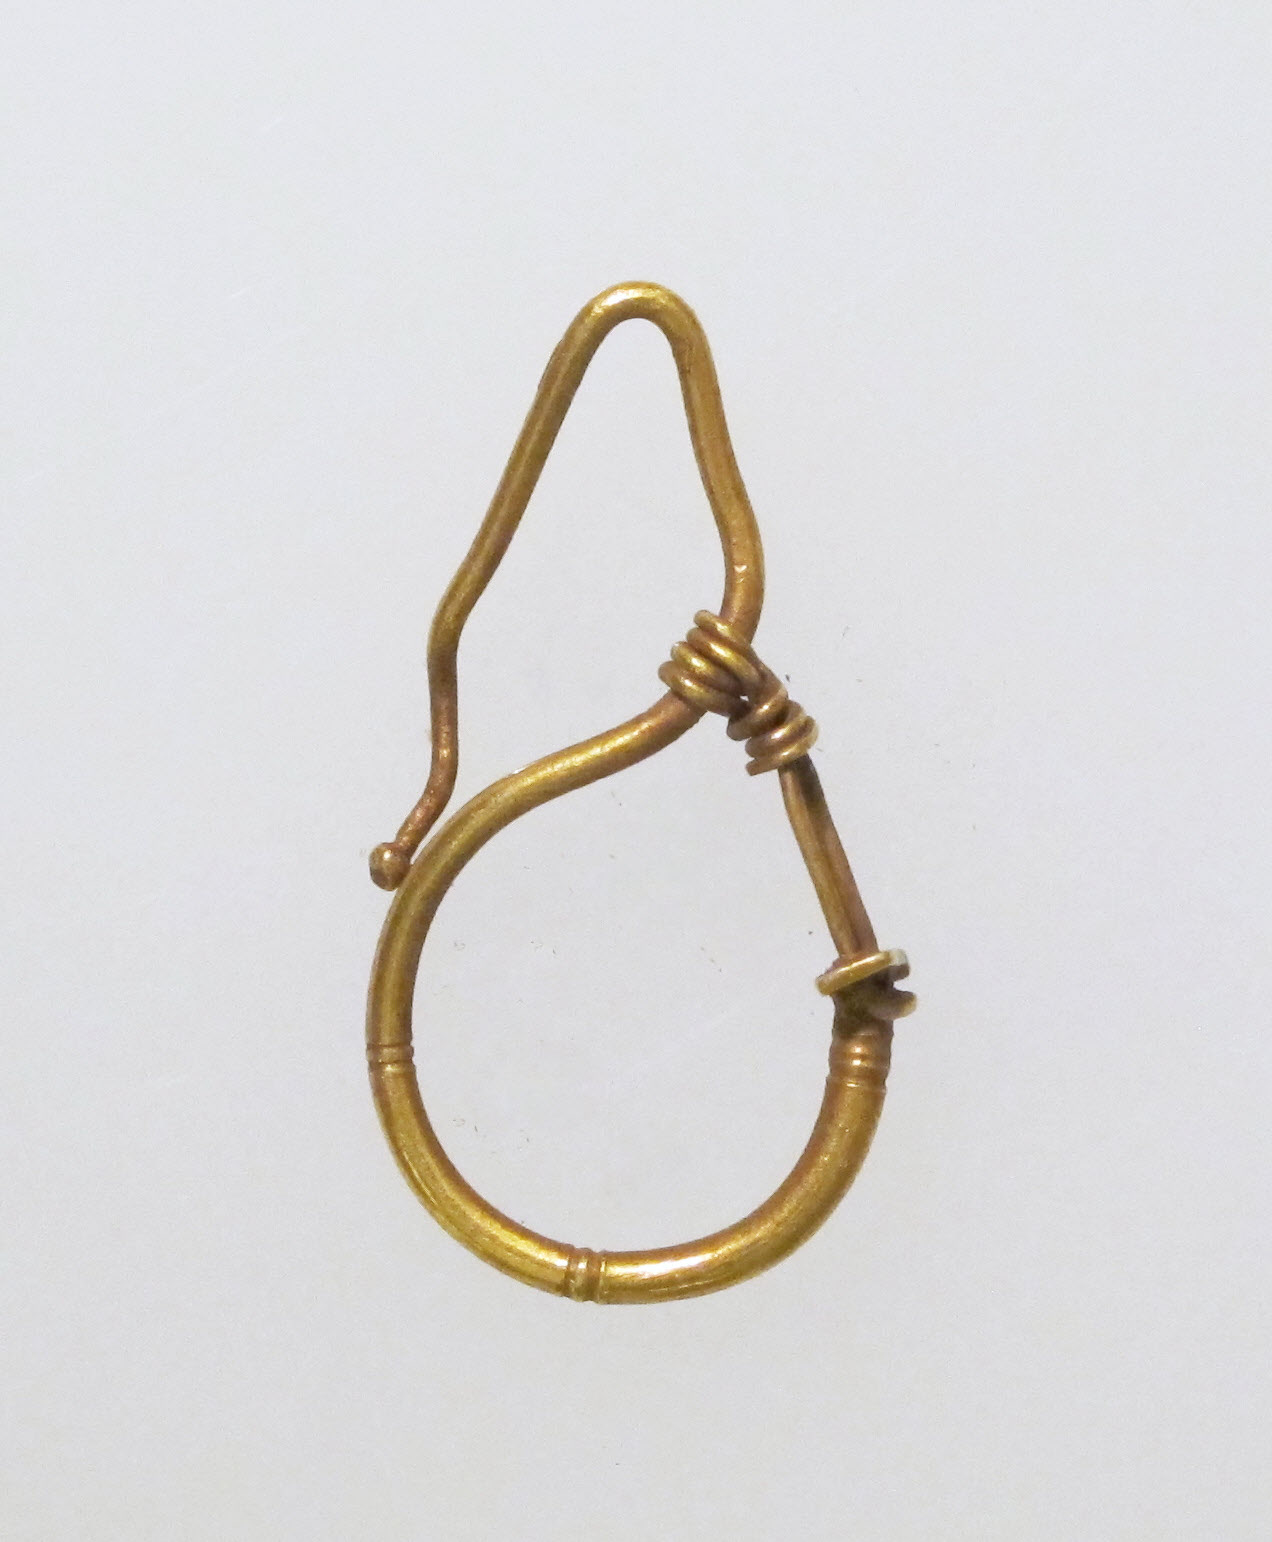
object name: earring, delta shaped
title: Earring, delta-shaped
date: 7000 BCE-330 CE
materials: gold